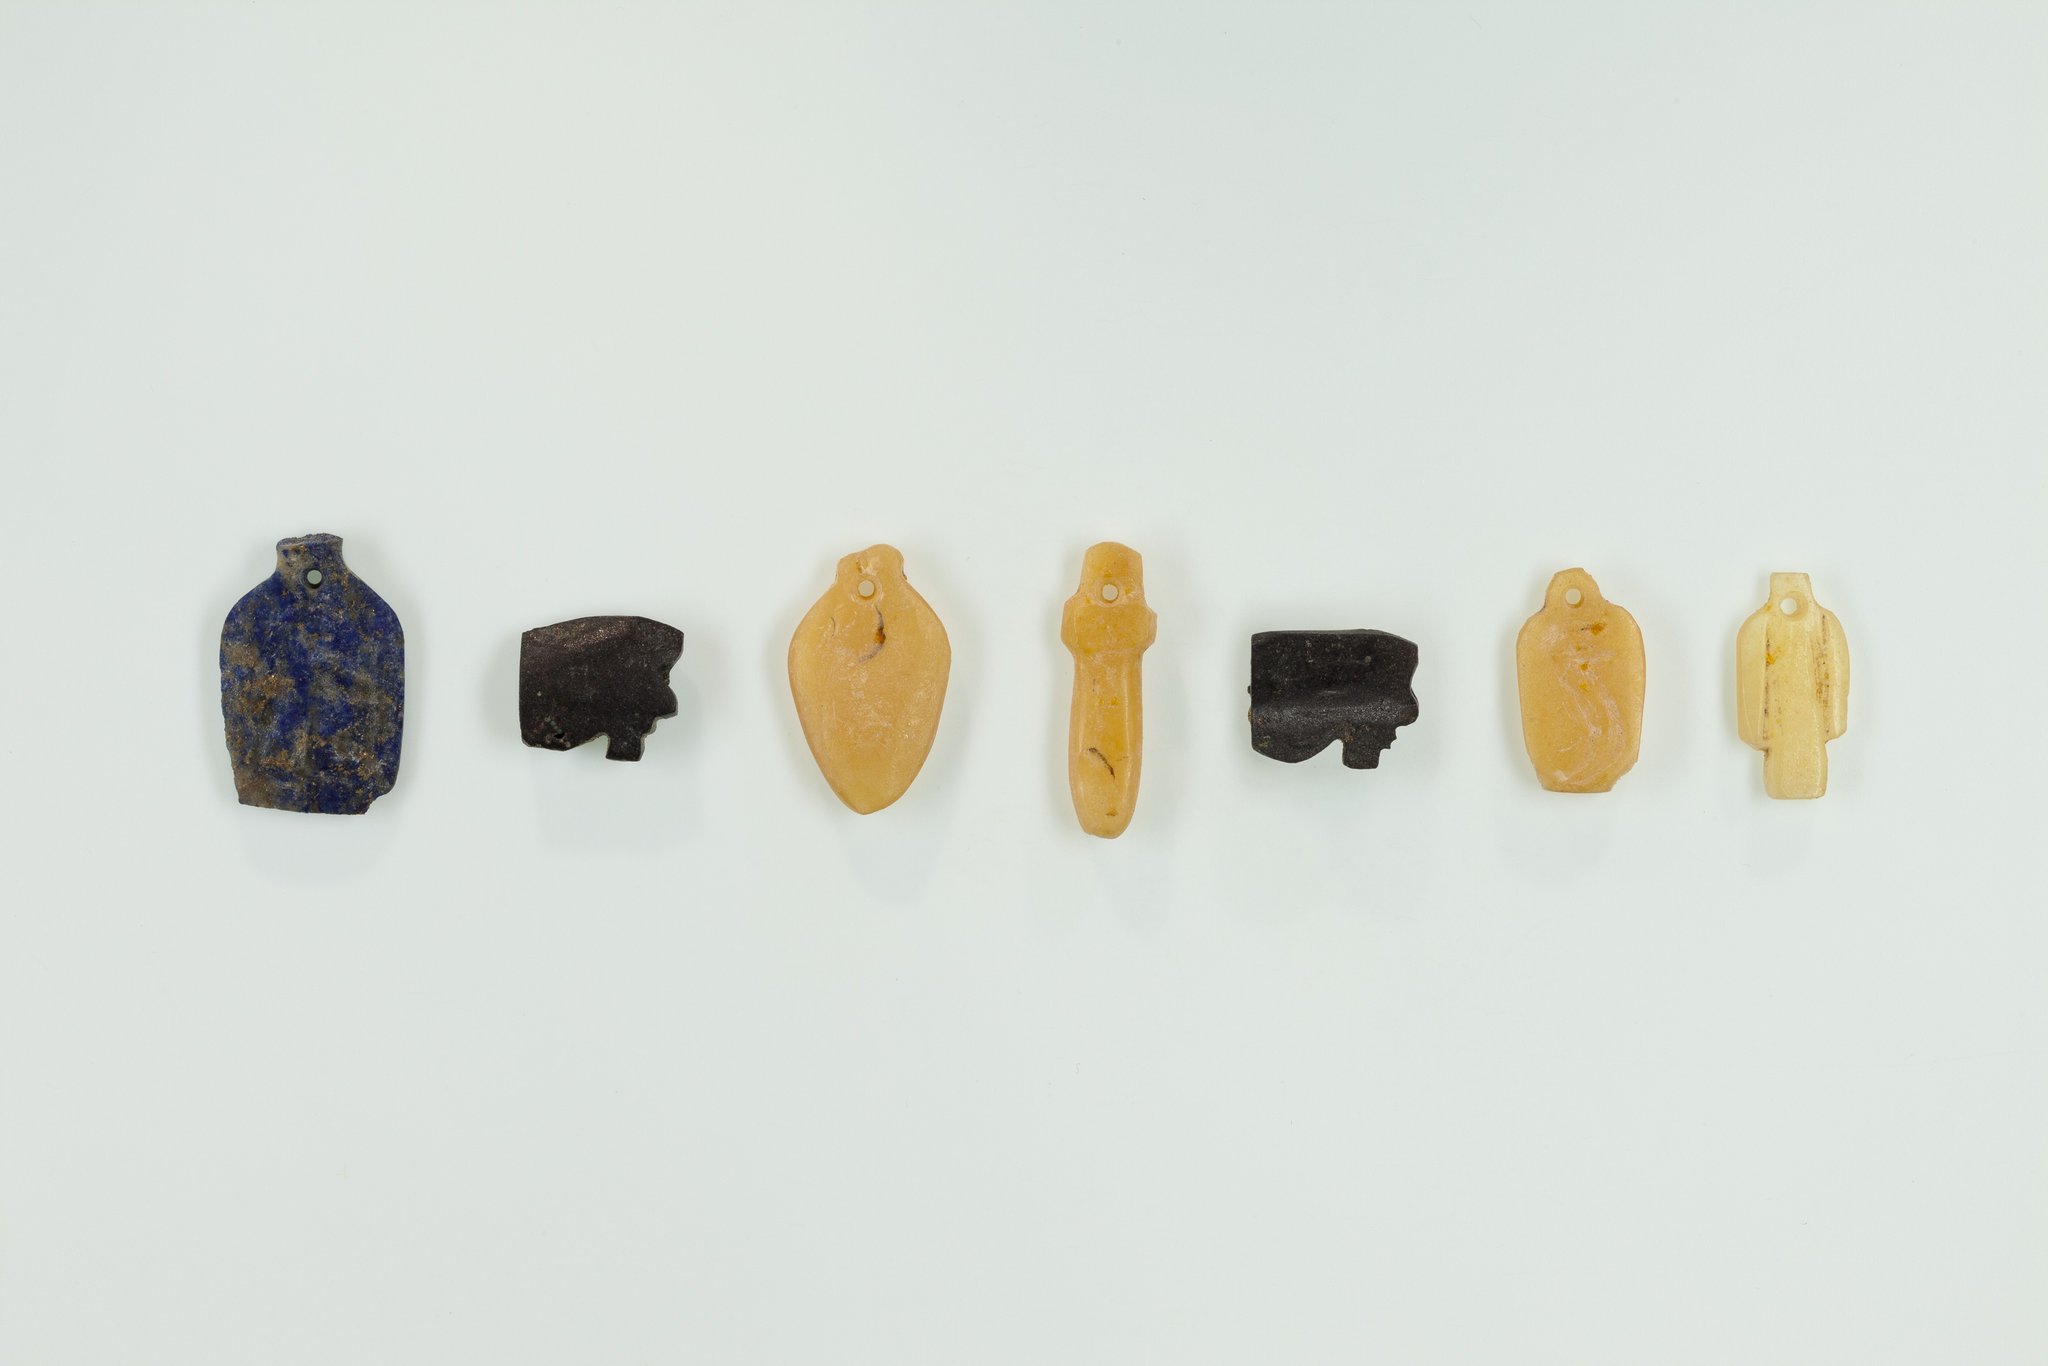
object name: amulet, djed pillar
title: Group of 7 amulets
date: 1070-945 BCE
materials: gemstone, mineral, lapis lazuli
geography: egypt